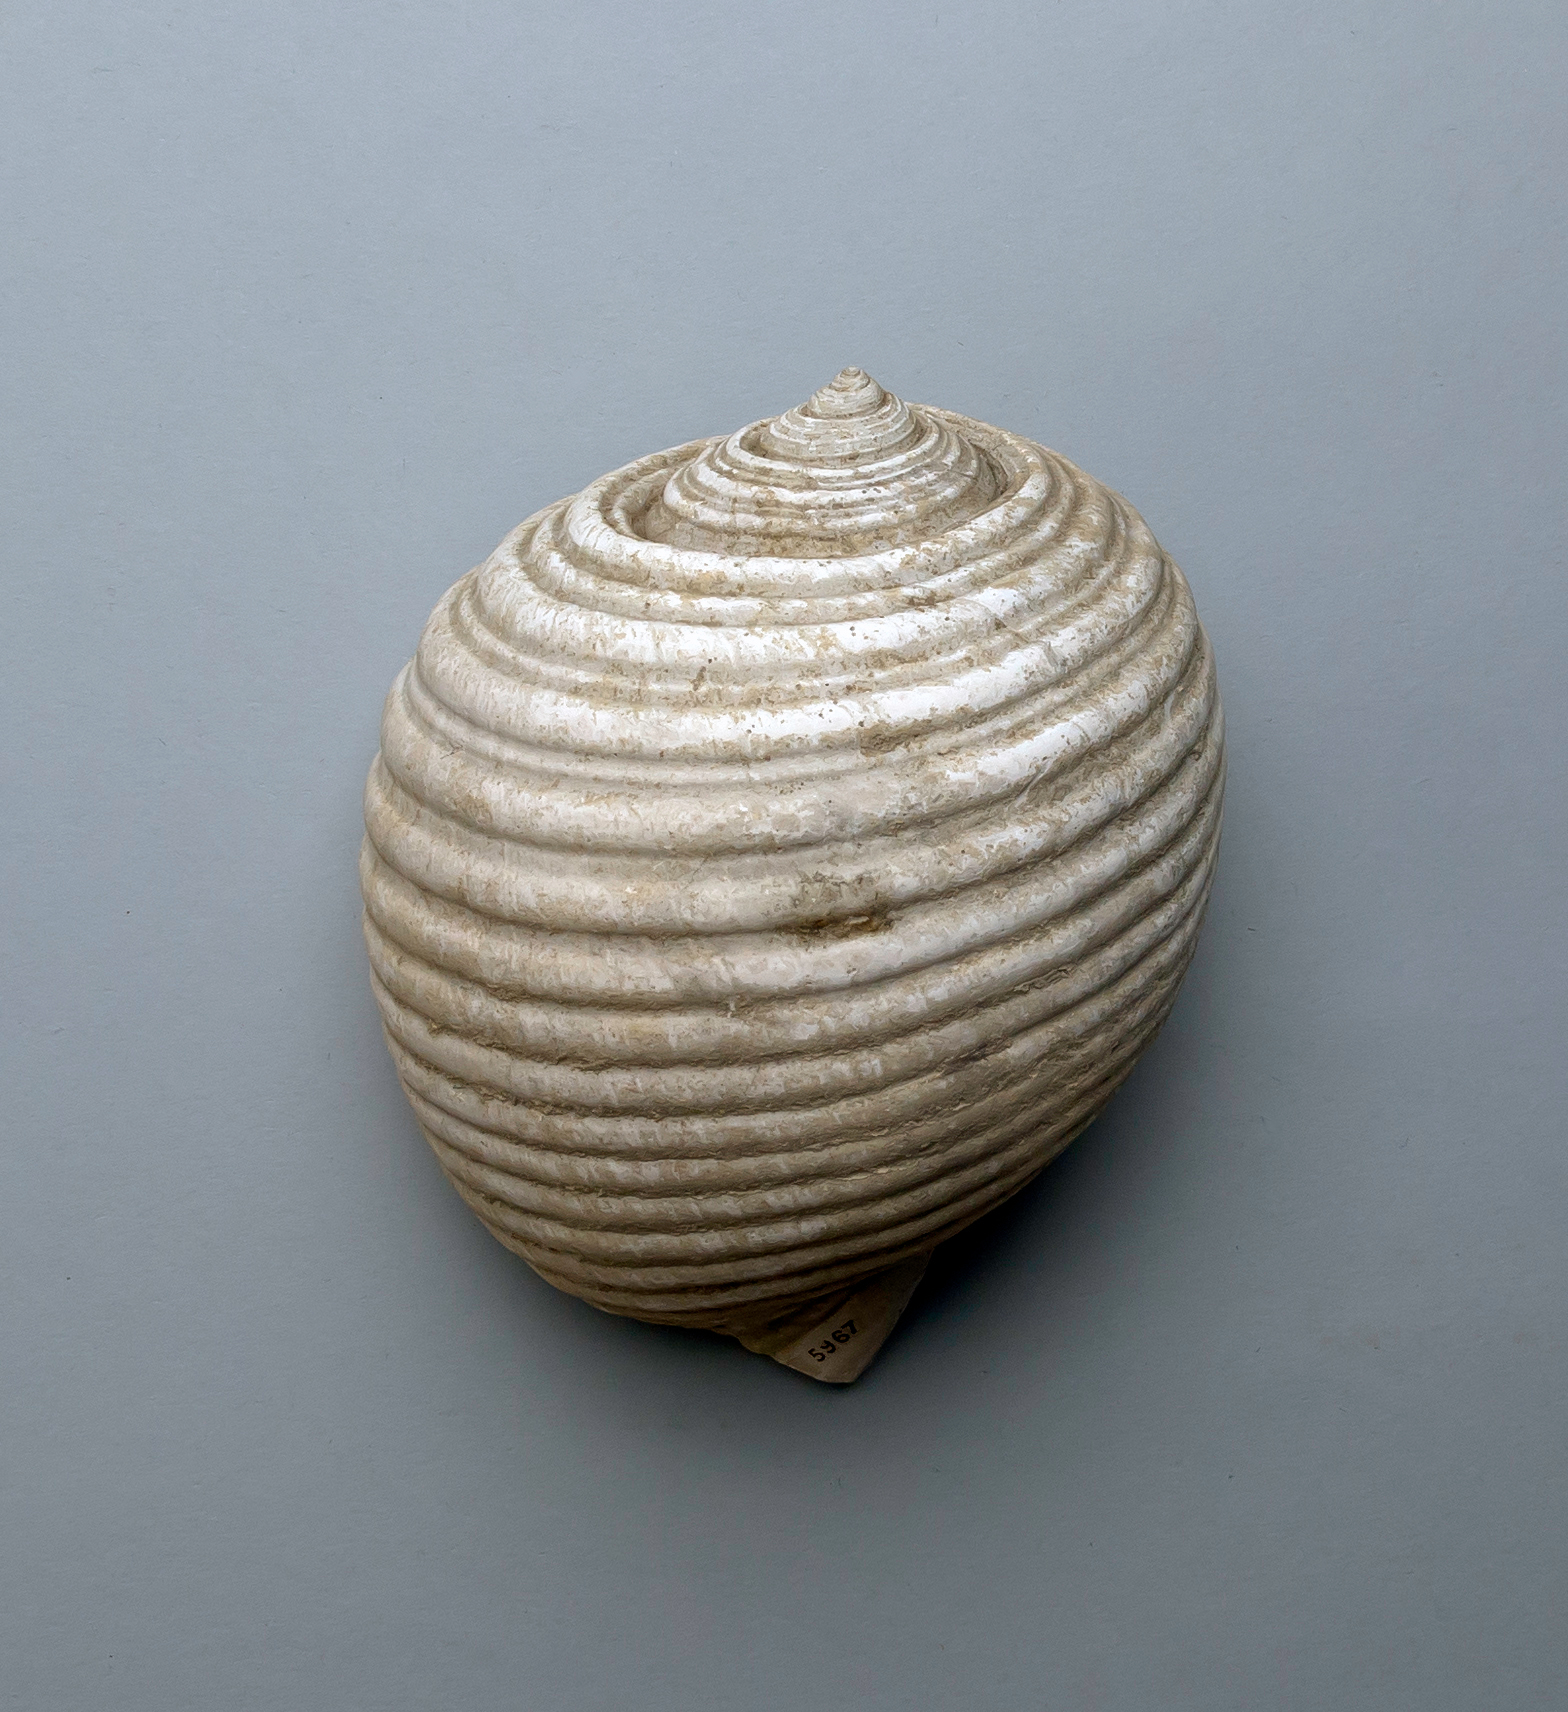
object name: shell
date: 7000 BCE-330 CE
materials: shell